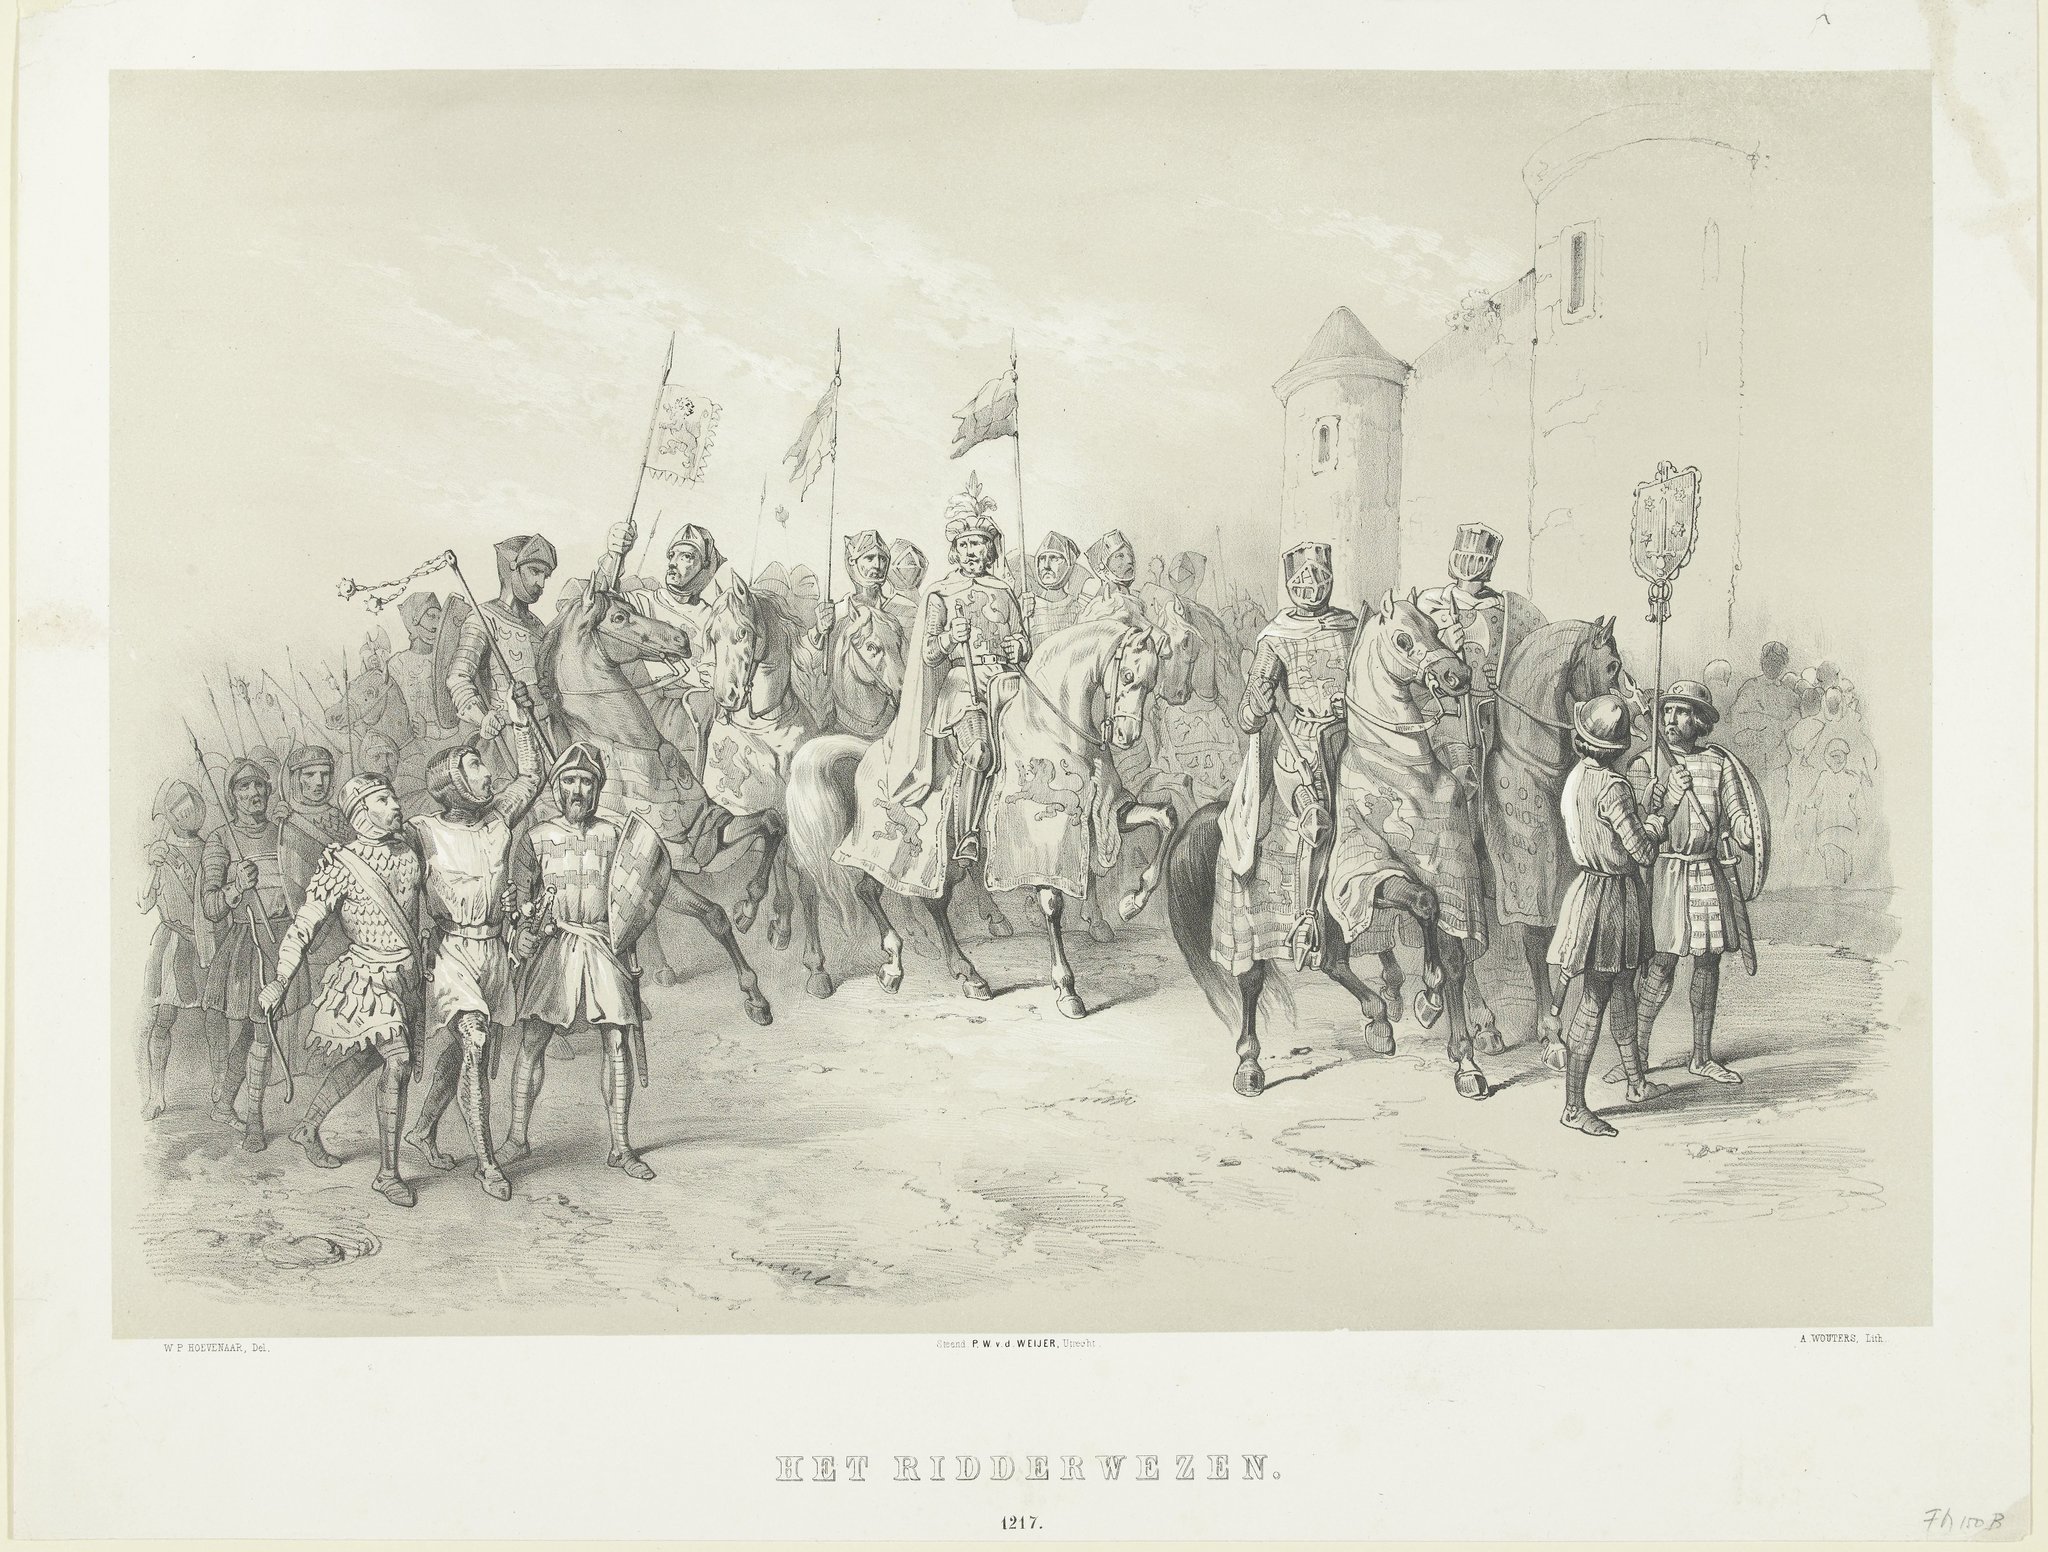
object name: history print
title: Ridders te paard, 1217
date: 1840-1863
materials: paper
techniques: lithograph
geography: utrecht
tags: knight, netherlands, haarlem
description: Vorst omringd door zijn ridders, allen te paard buiten een kasteel, in het jaar 1217. Rechts een standaarddrager met een standaard waarop het wapen van Haarlem.